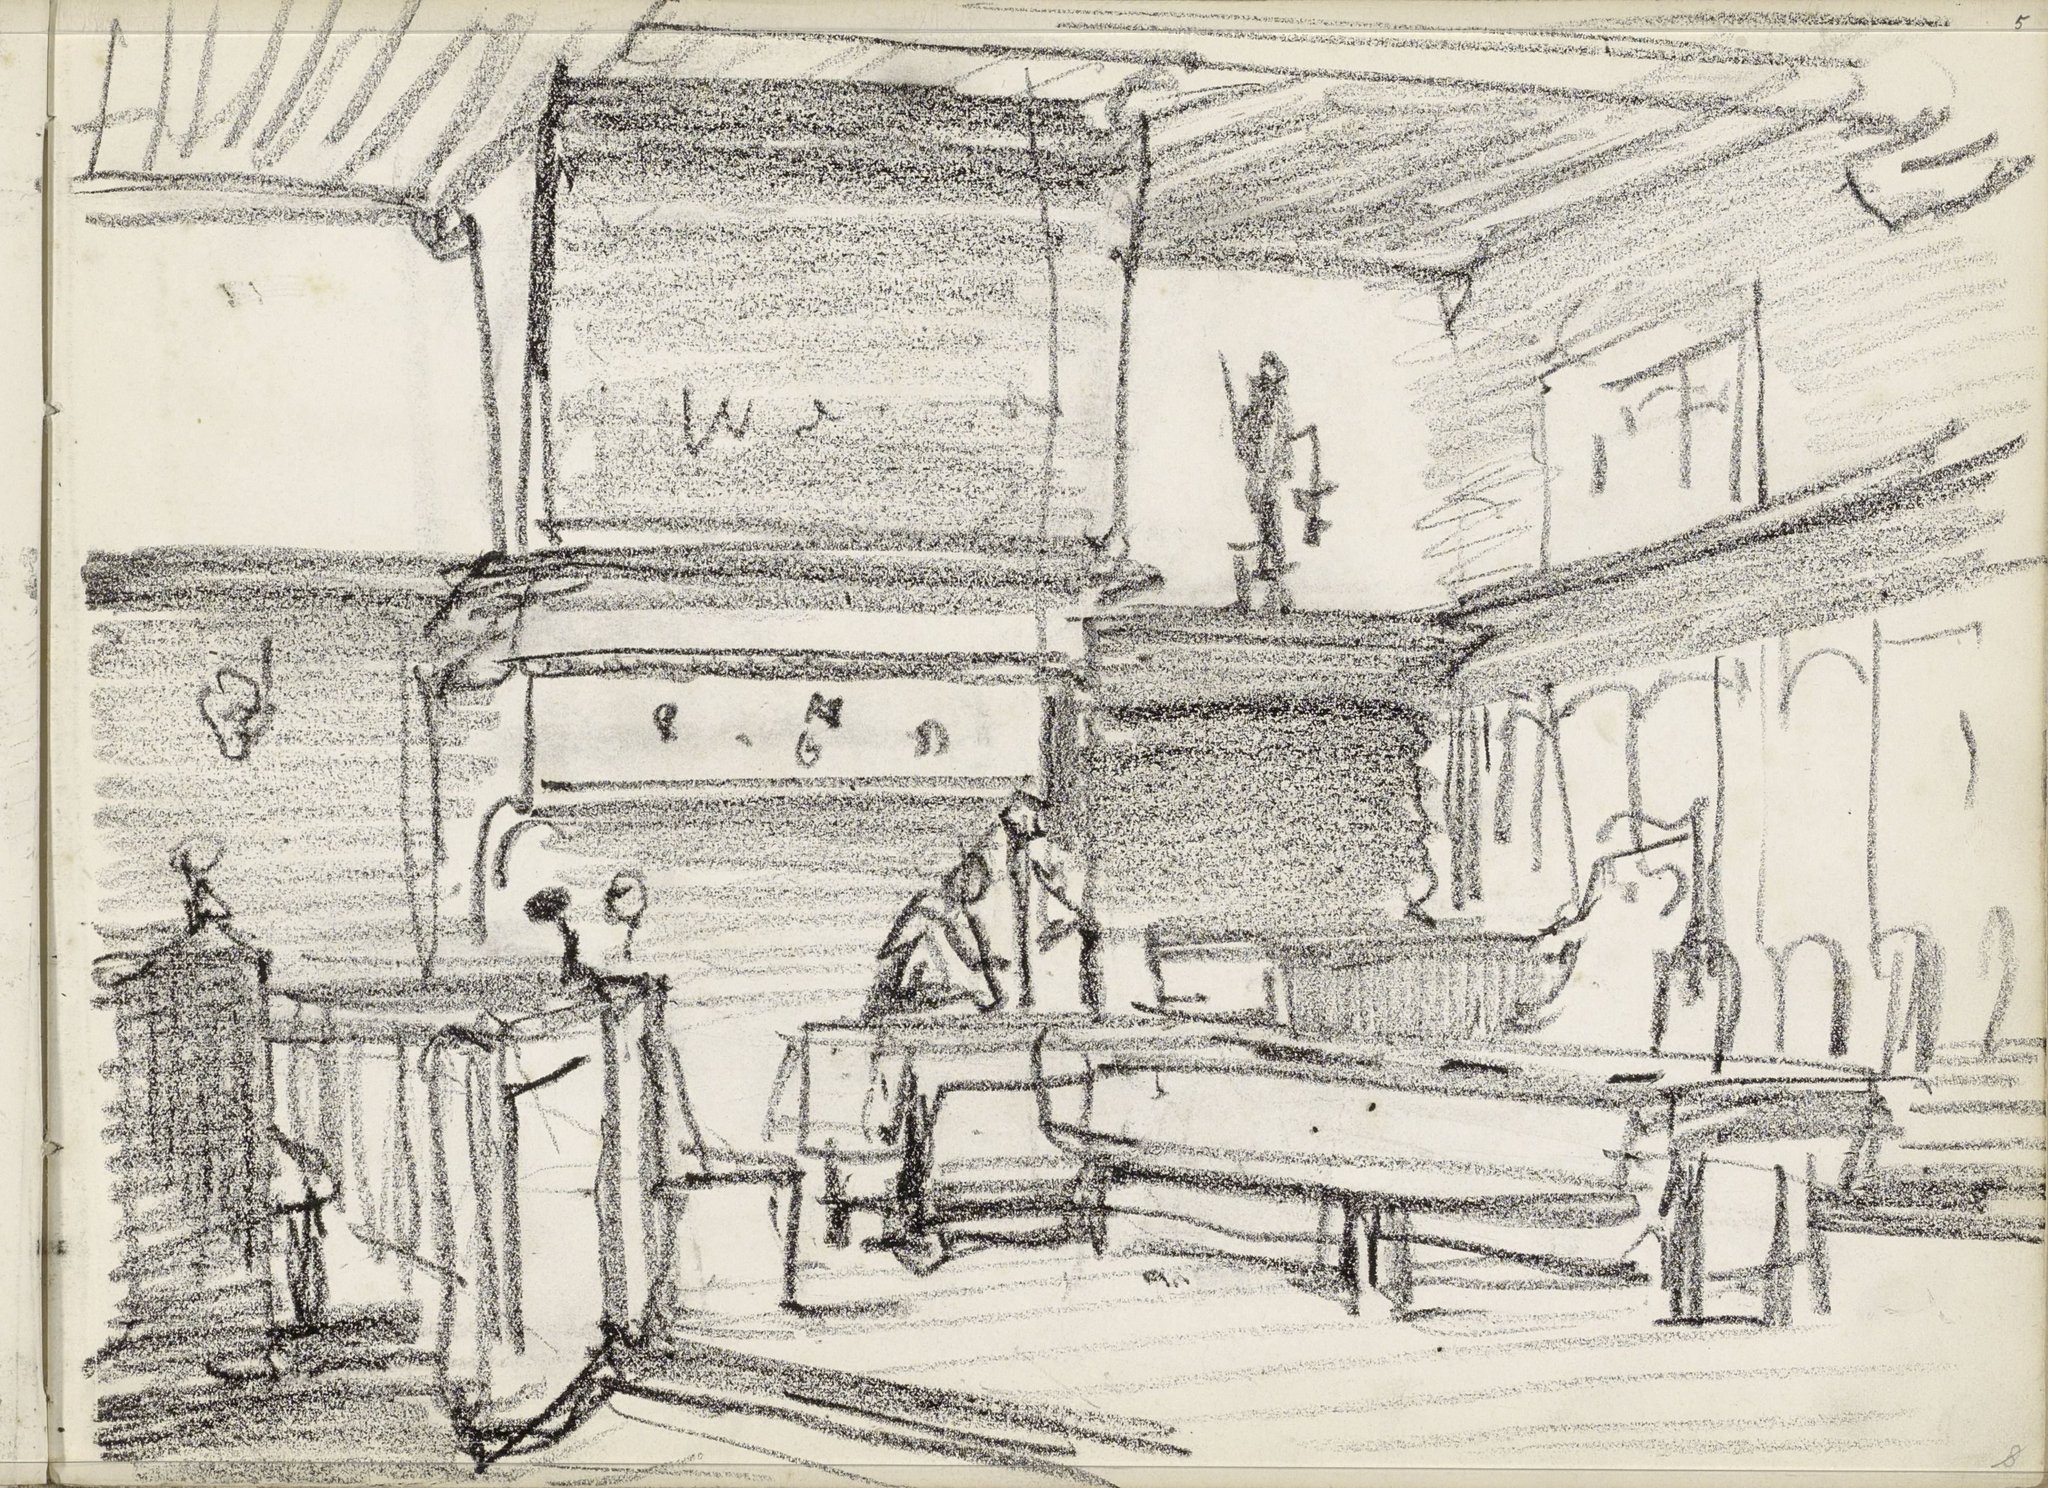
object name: sketchbook leaf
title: Interieur, mogelijk van het Muiderslot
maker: johannes bosboom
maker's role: draughtsman, painter, print maker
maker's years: 1817-1891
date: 1827-1891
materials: chalk, paper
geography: muiden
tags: interior ~ representation of a building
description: Blad 5 recto uit een schetsboek met 13 bladen.